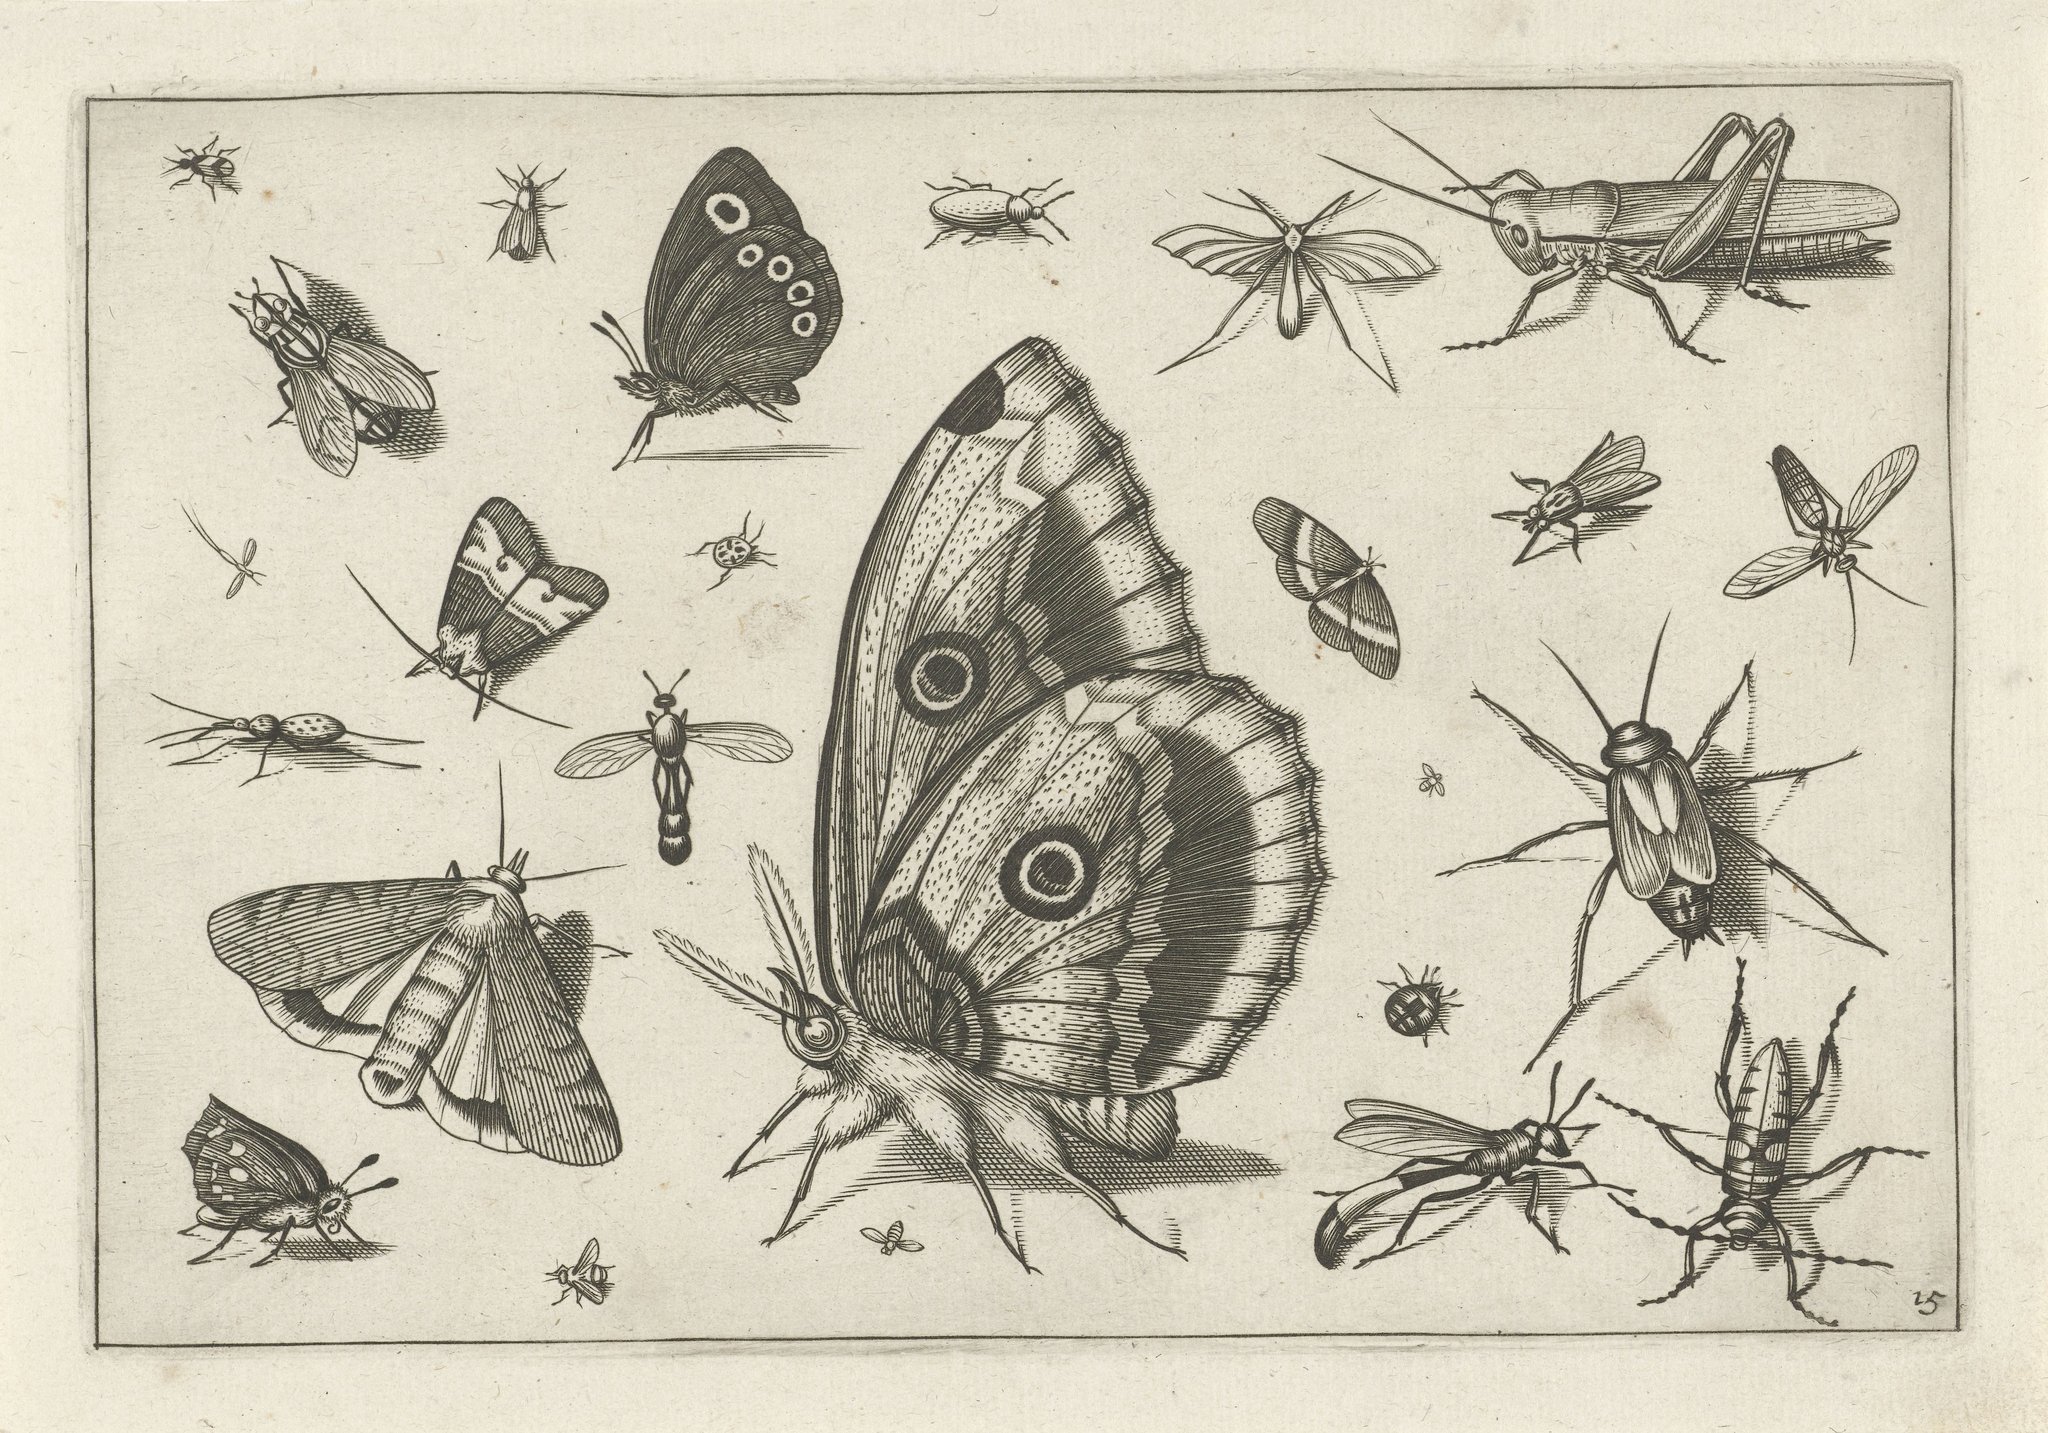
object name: print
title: Diversae Insectarum Volatilium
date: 1630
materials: paper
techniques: engraving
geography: amsterdam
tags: insects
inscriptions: collector's mark: Lugt 2228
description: Verschillende insecten met in het middden een mot.